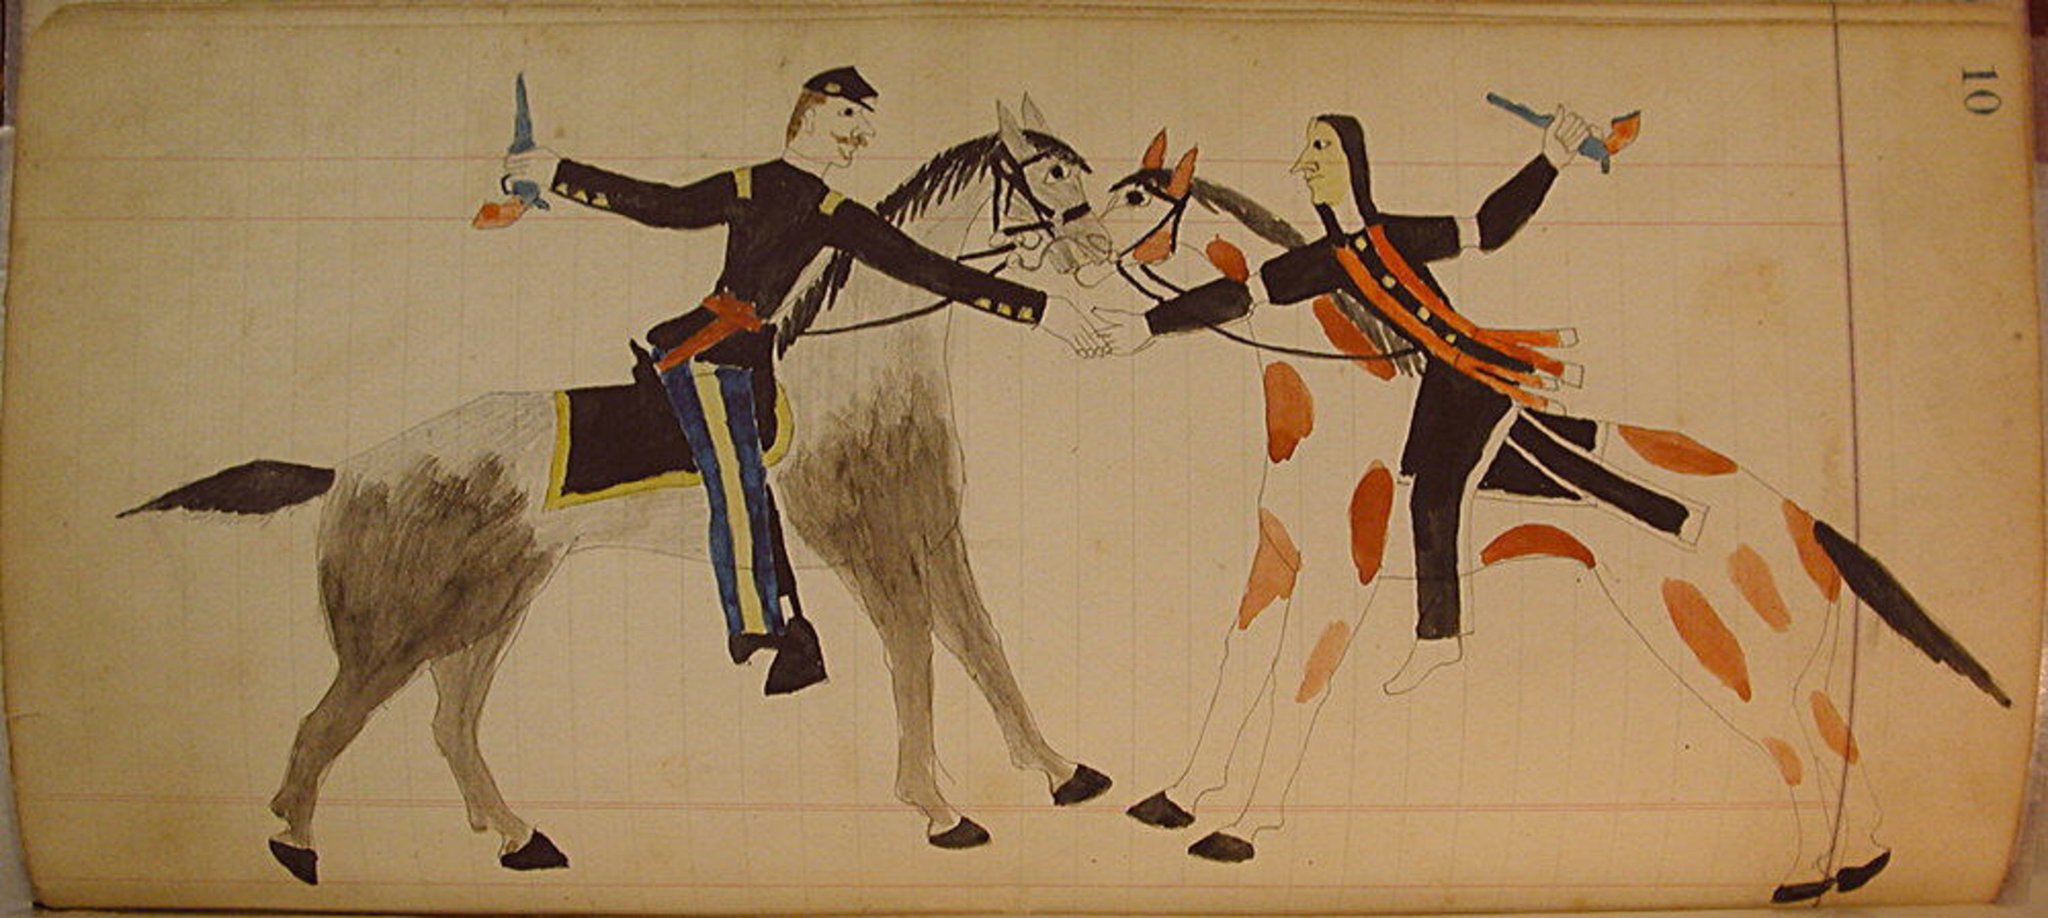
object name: drawing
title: Maffet Ledger: Mounted Soldier and Indian Shaking Hands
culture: cheyenne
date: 1874-1881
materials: crayon, graphite, paper, watercolor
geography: united states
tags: soldiers,men,women,horses